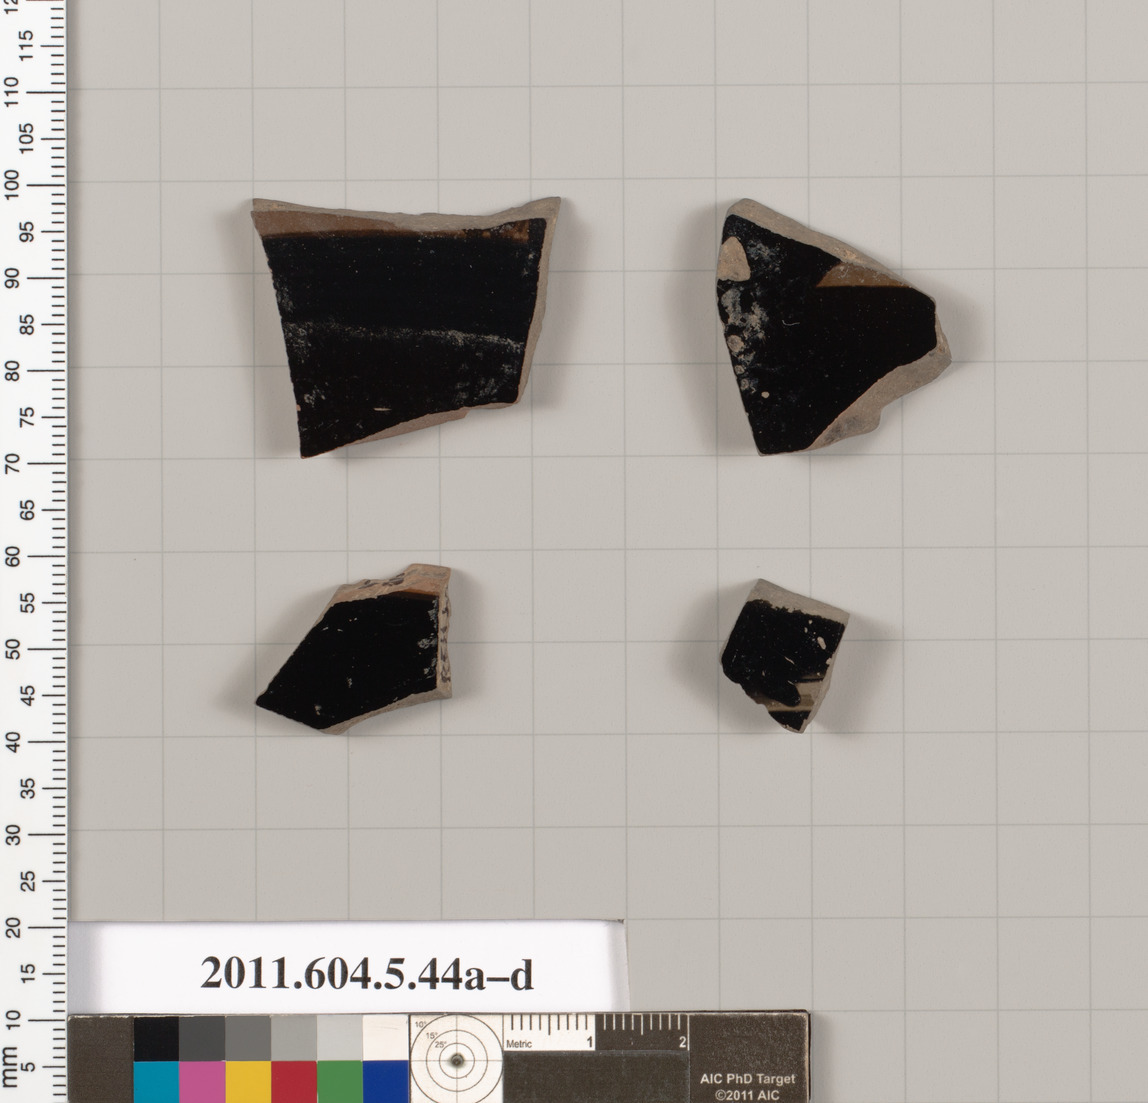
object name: kylix fragment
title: Terracotta fragments of kylikes (drinking cups)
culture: greek, attic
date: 500-401 BCE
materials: terracotta